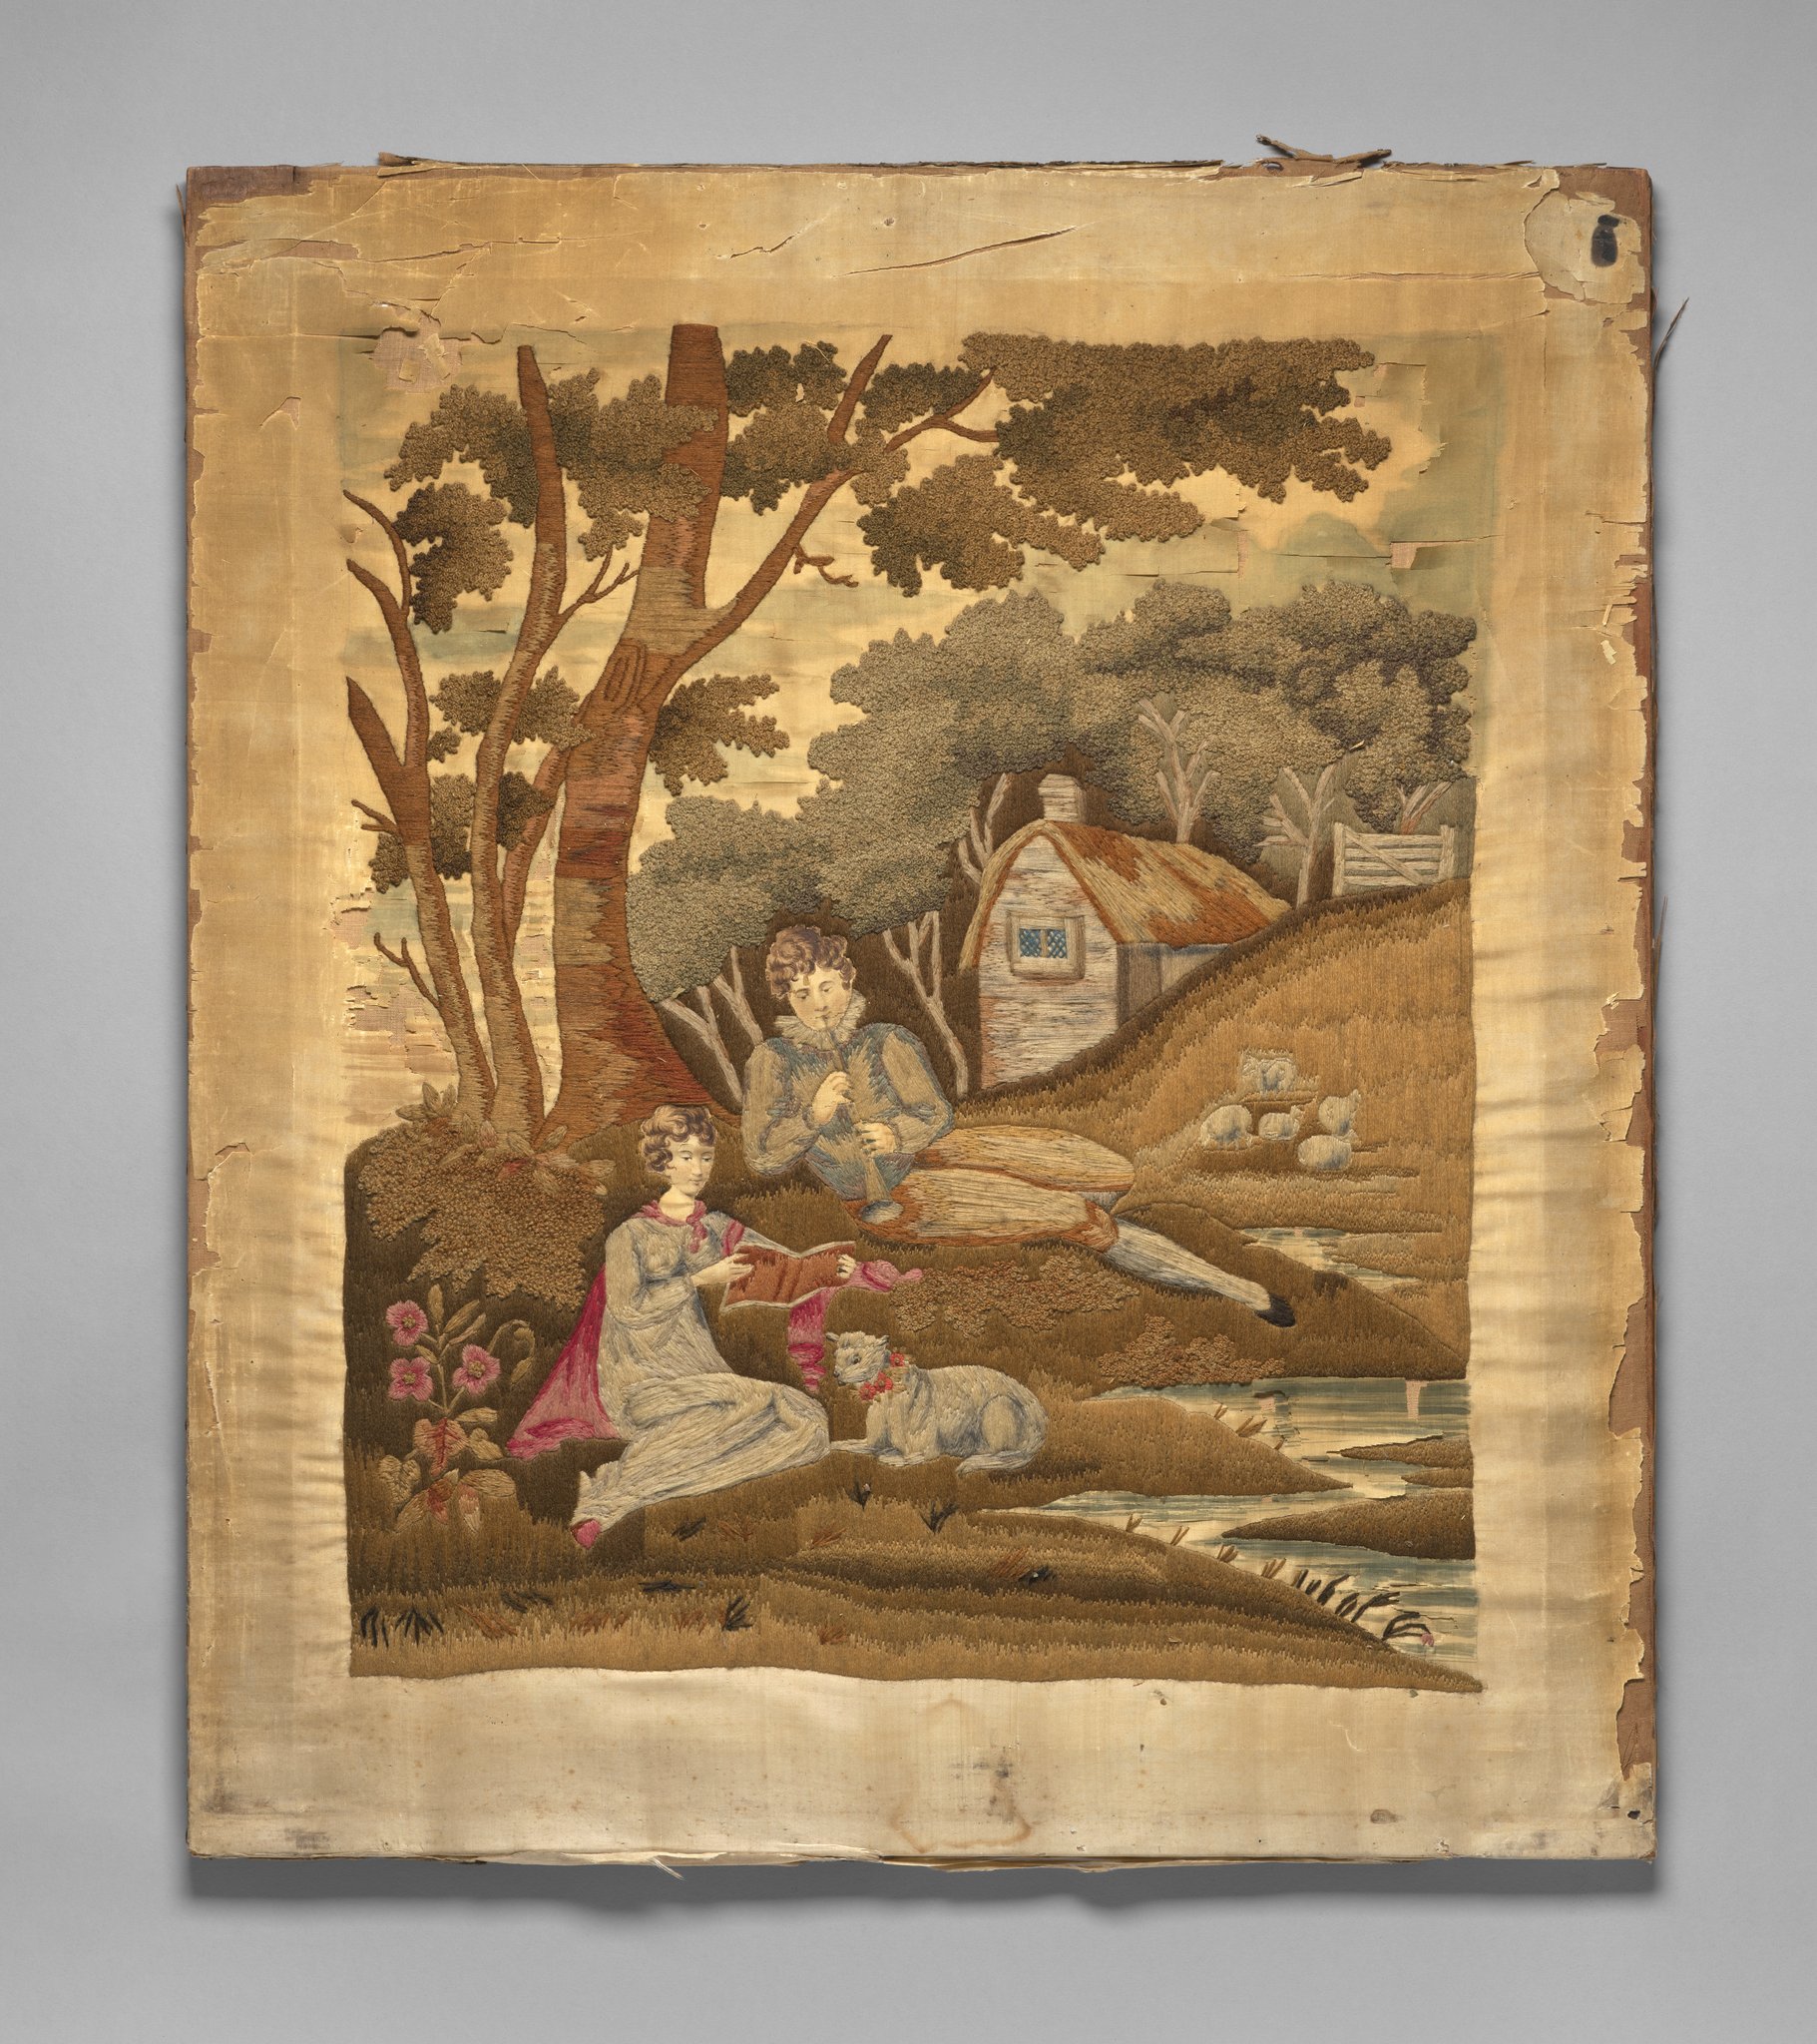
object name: panel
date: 1801-1833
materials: silk, wool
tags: books,men,women,reading,lambs